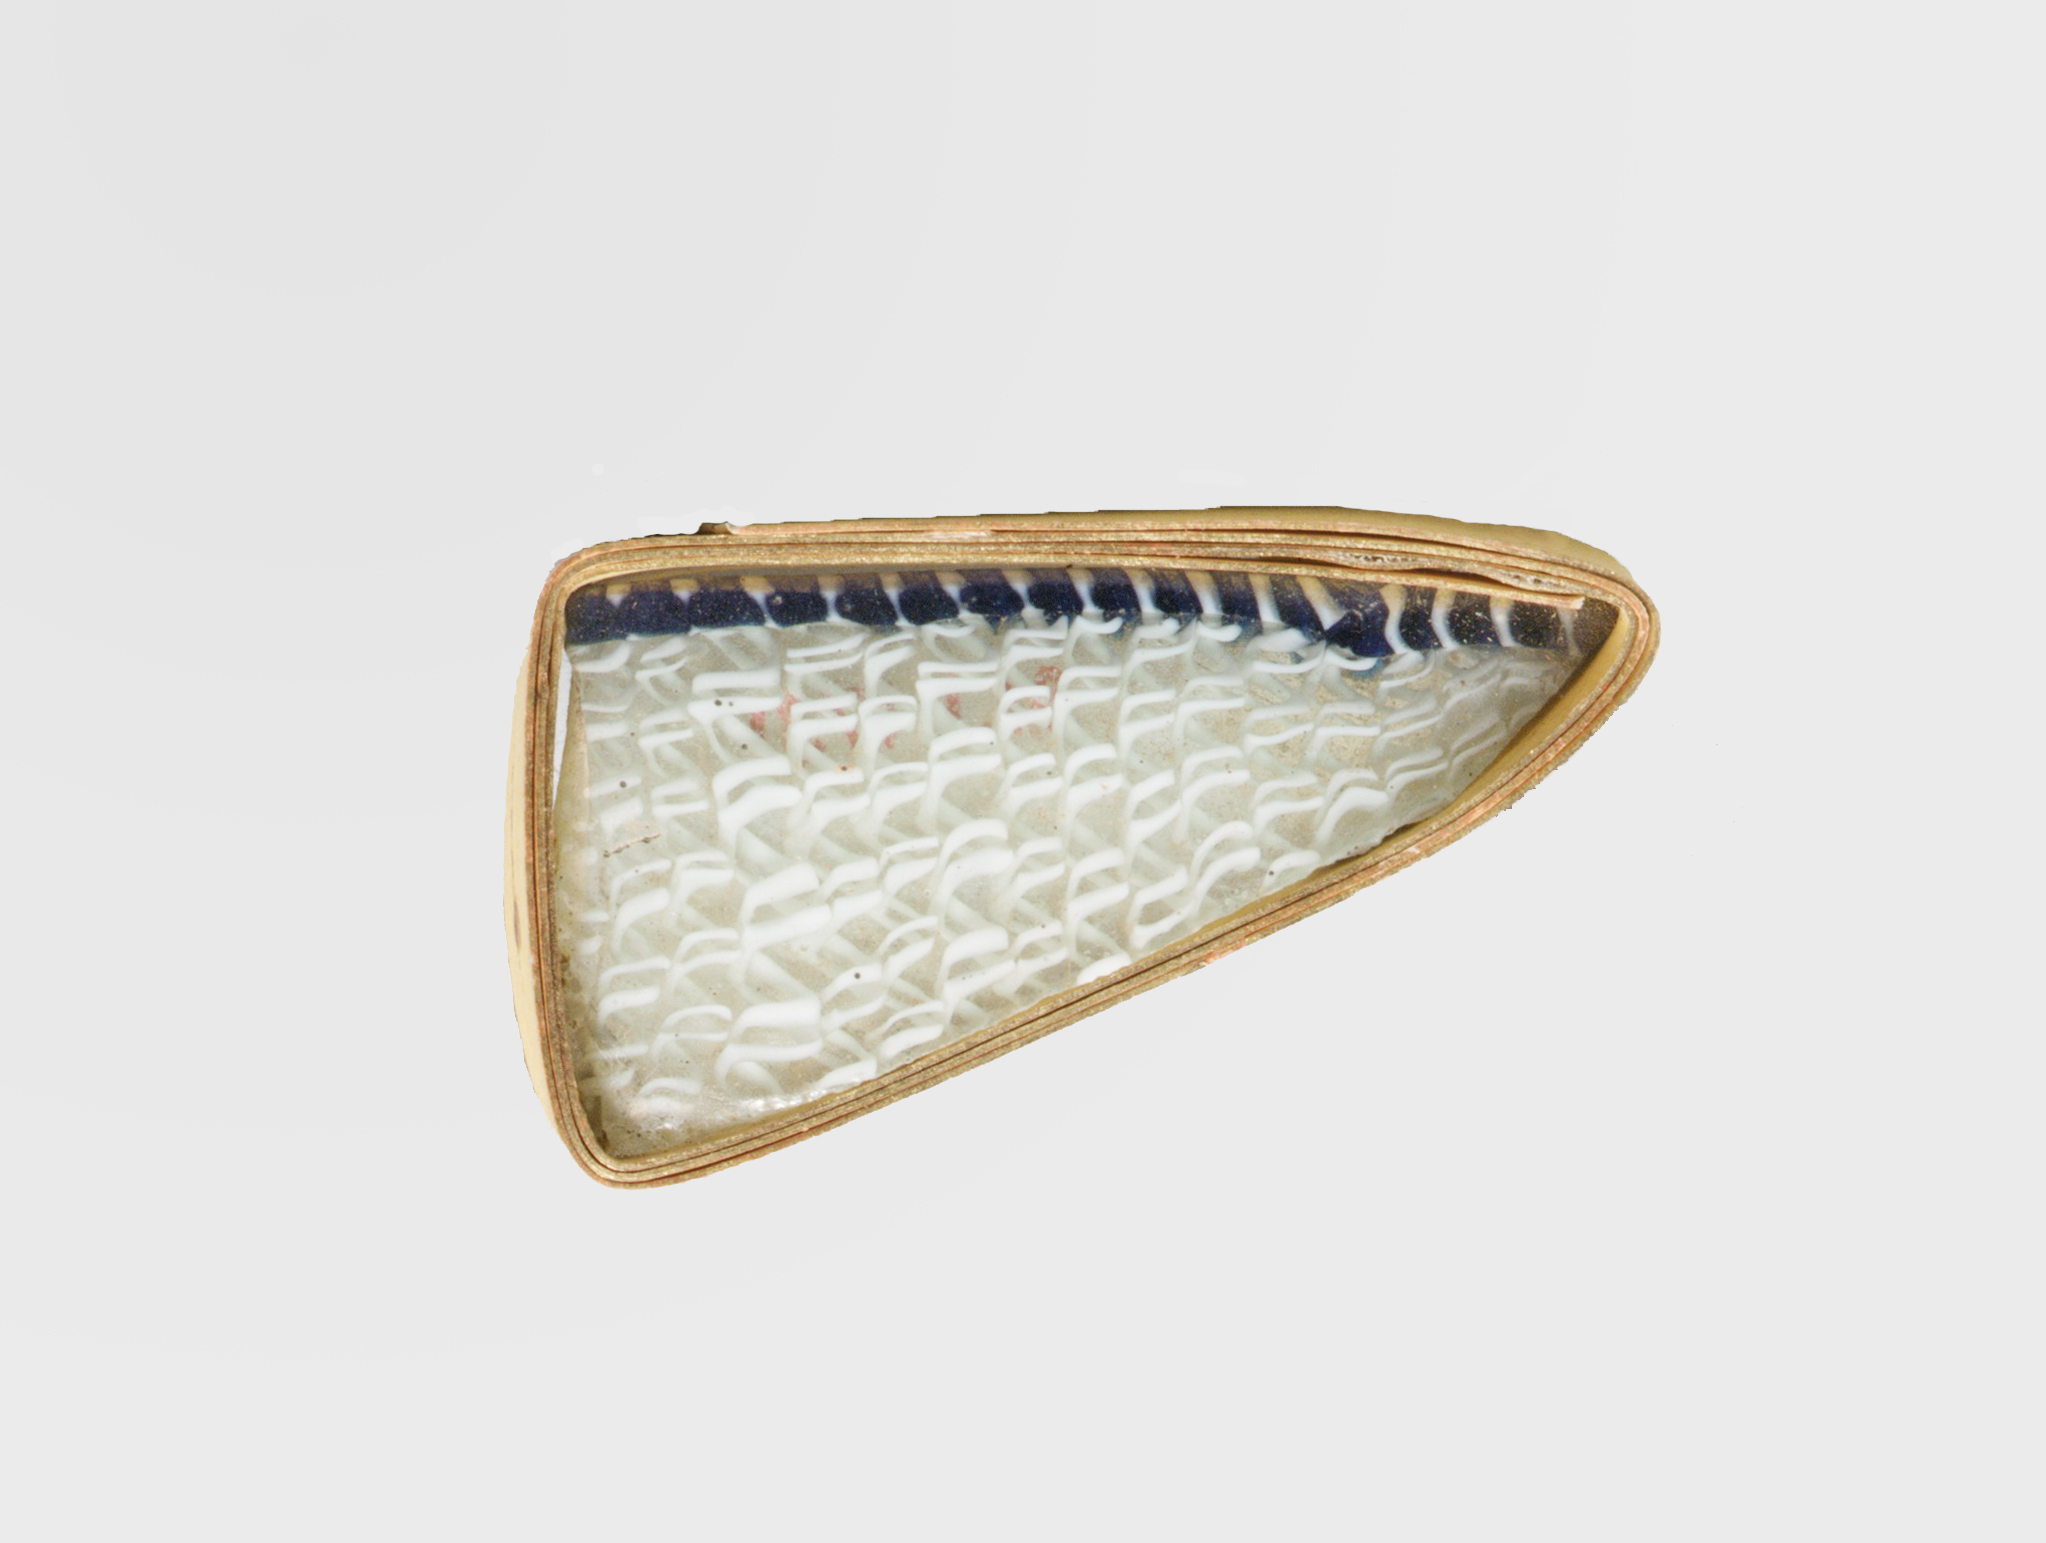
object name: fragment, network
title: Glass network mosaic bowl fragment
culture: roman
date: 34 BCE-33 CE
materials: glass